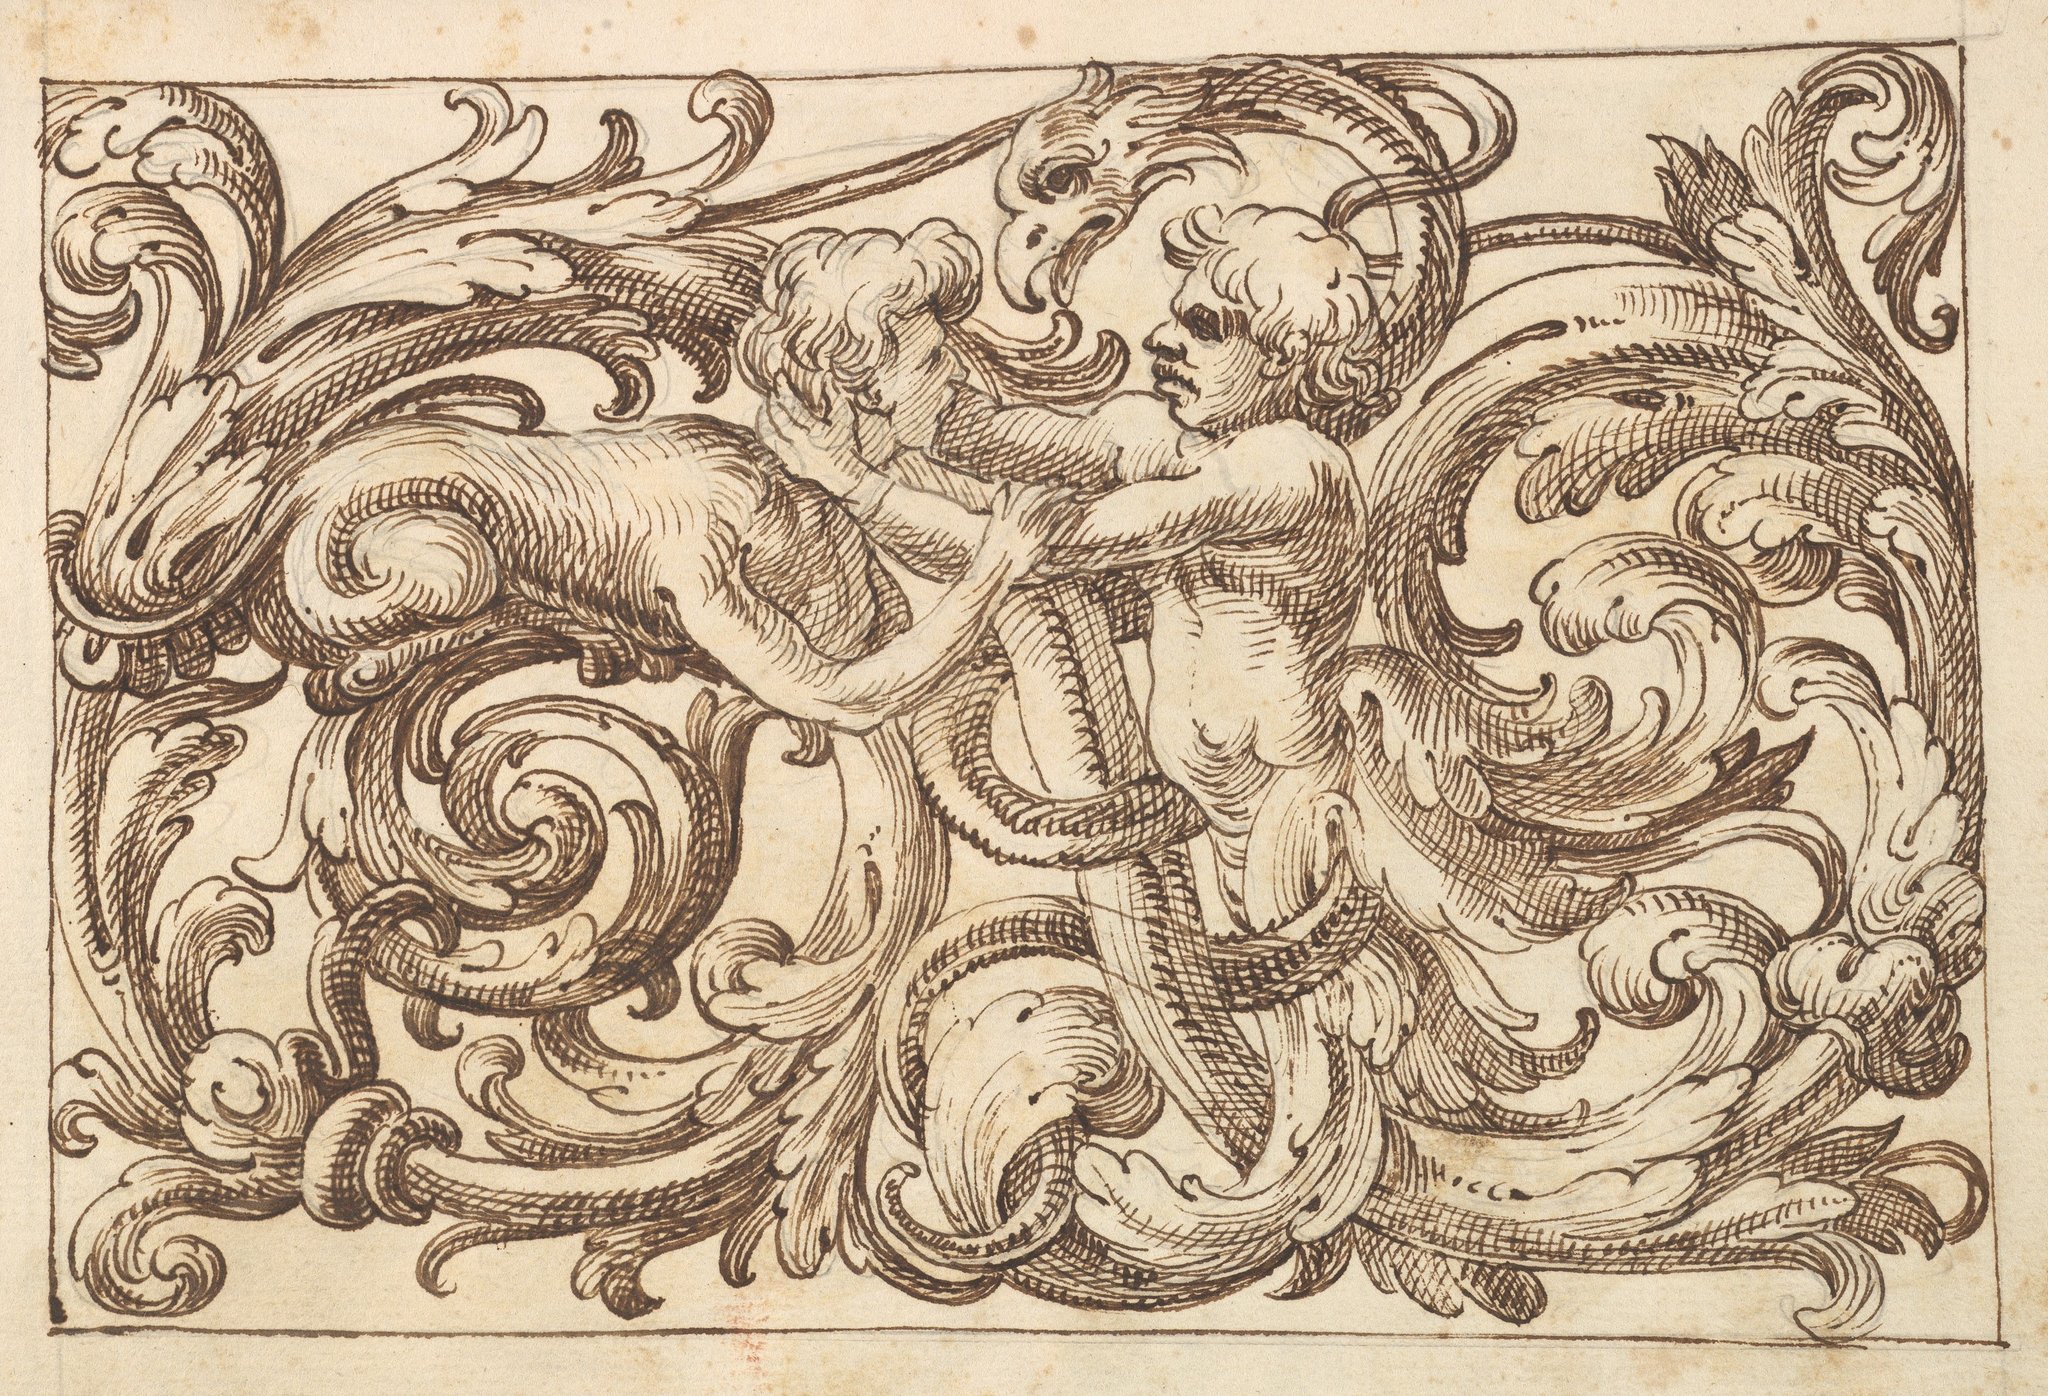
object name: collection ornament architecture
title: Horizontal Panel Design with a Man fighting a Sphinx and a Fantastical Creature Interspersed between Acanthus Rinceaux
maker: anonymous, italian, venetian, 17th century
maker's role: artist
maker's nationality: italian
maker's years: 1600-1700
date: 1601-1700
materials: ink, drawing material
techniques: pen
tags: men,sphinx